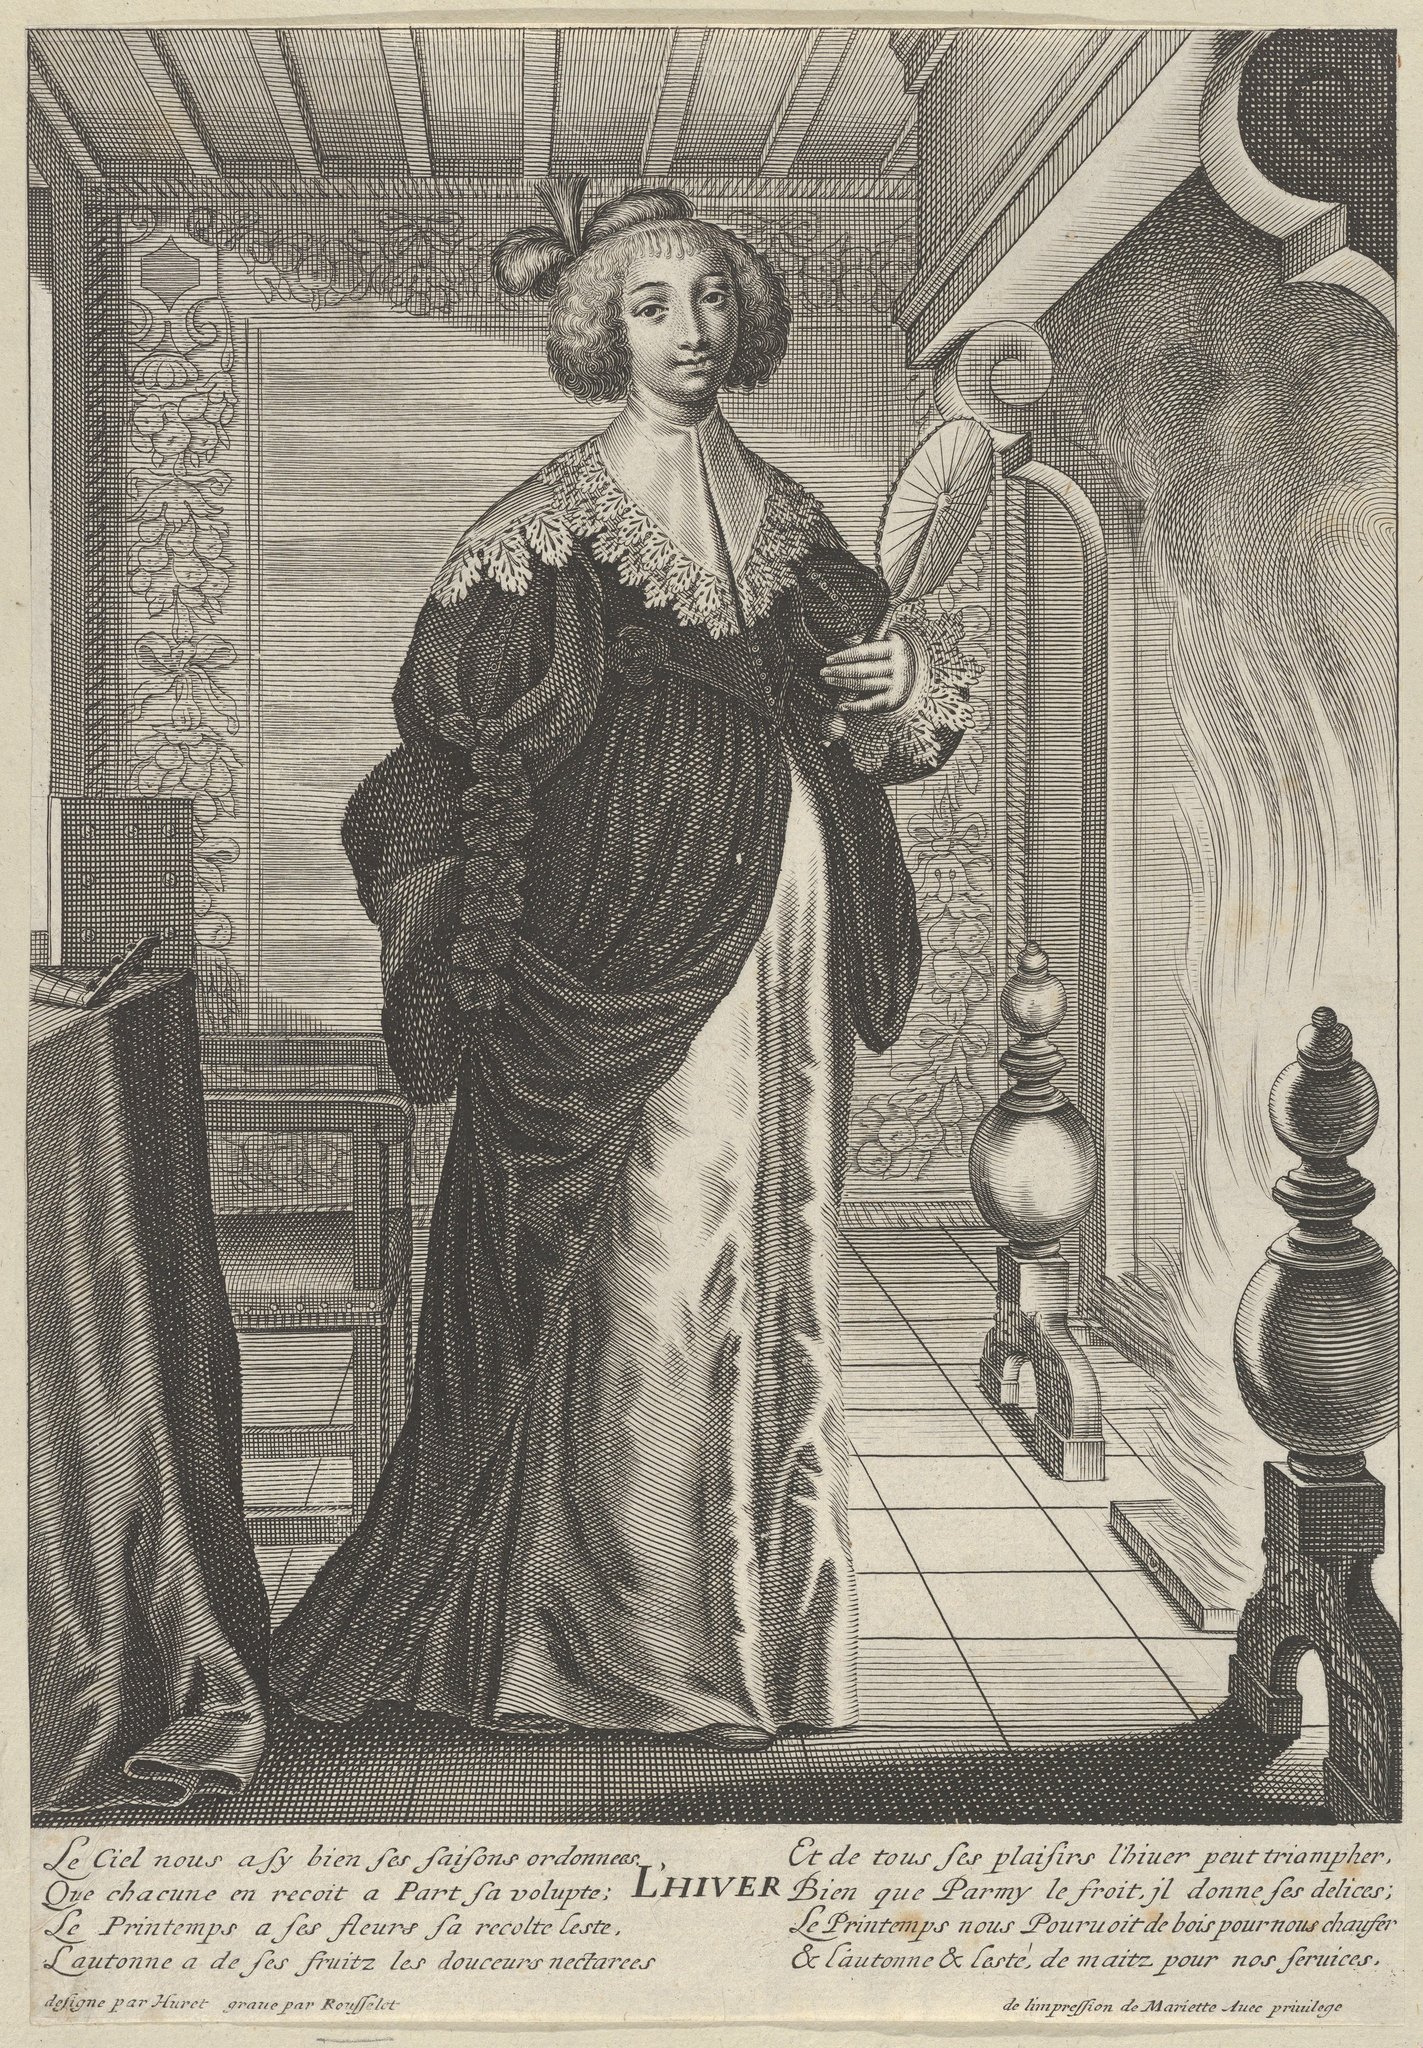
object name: print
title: Winter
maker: gilles rousselet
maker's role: artist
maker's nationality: french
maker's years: 1614-1686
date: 1601-1700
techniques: engraving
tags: fireplaces,women